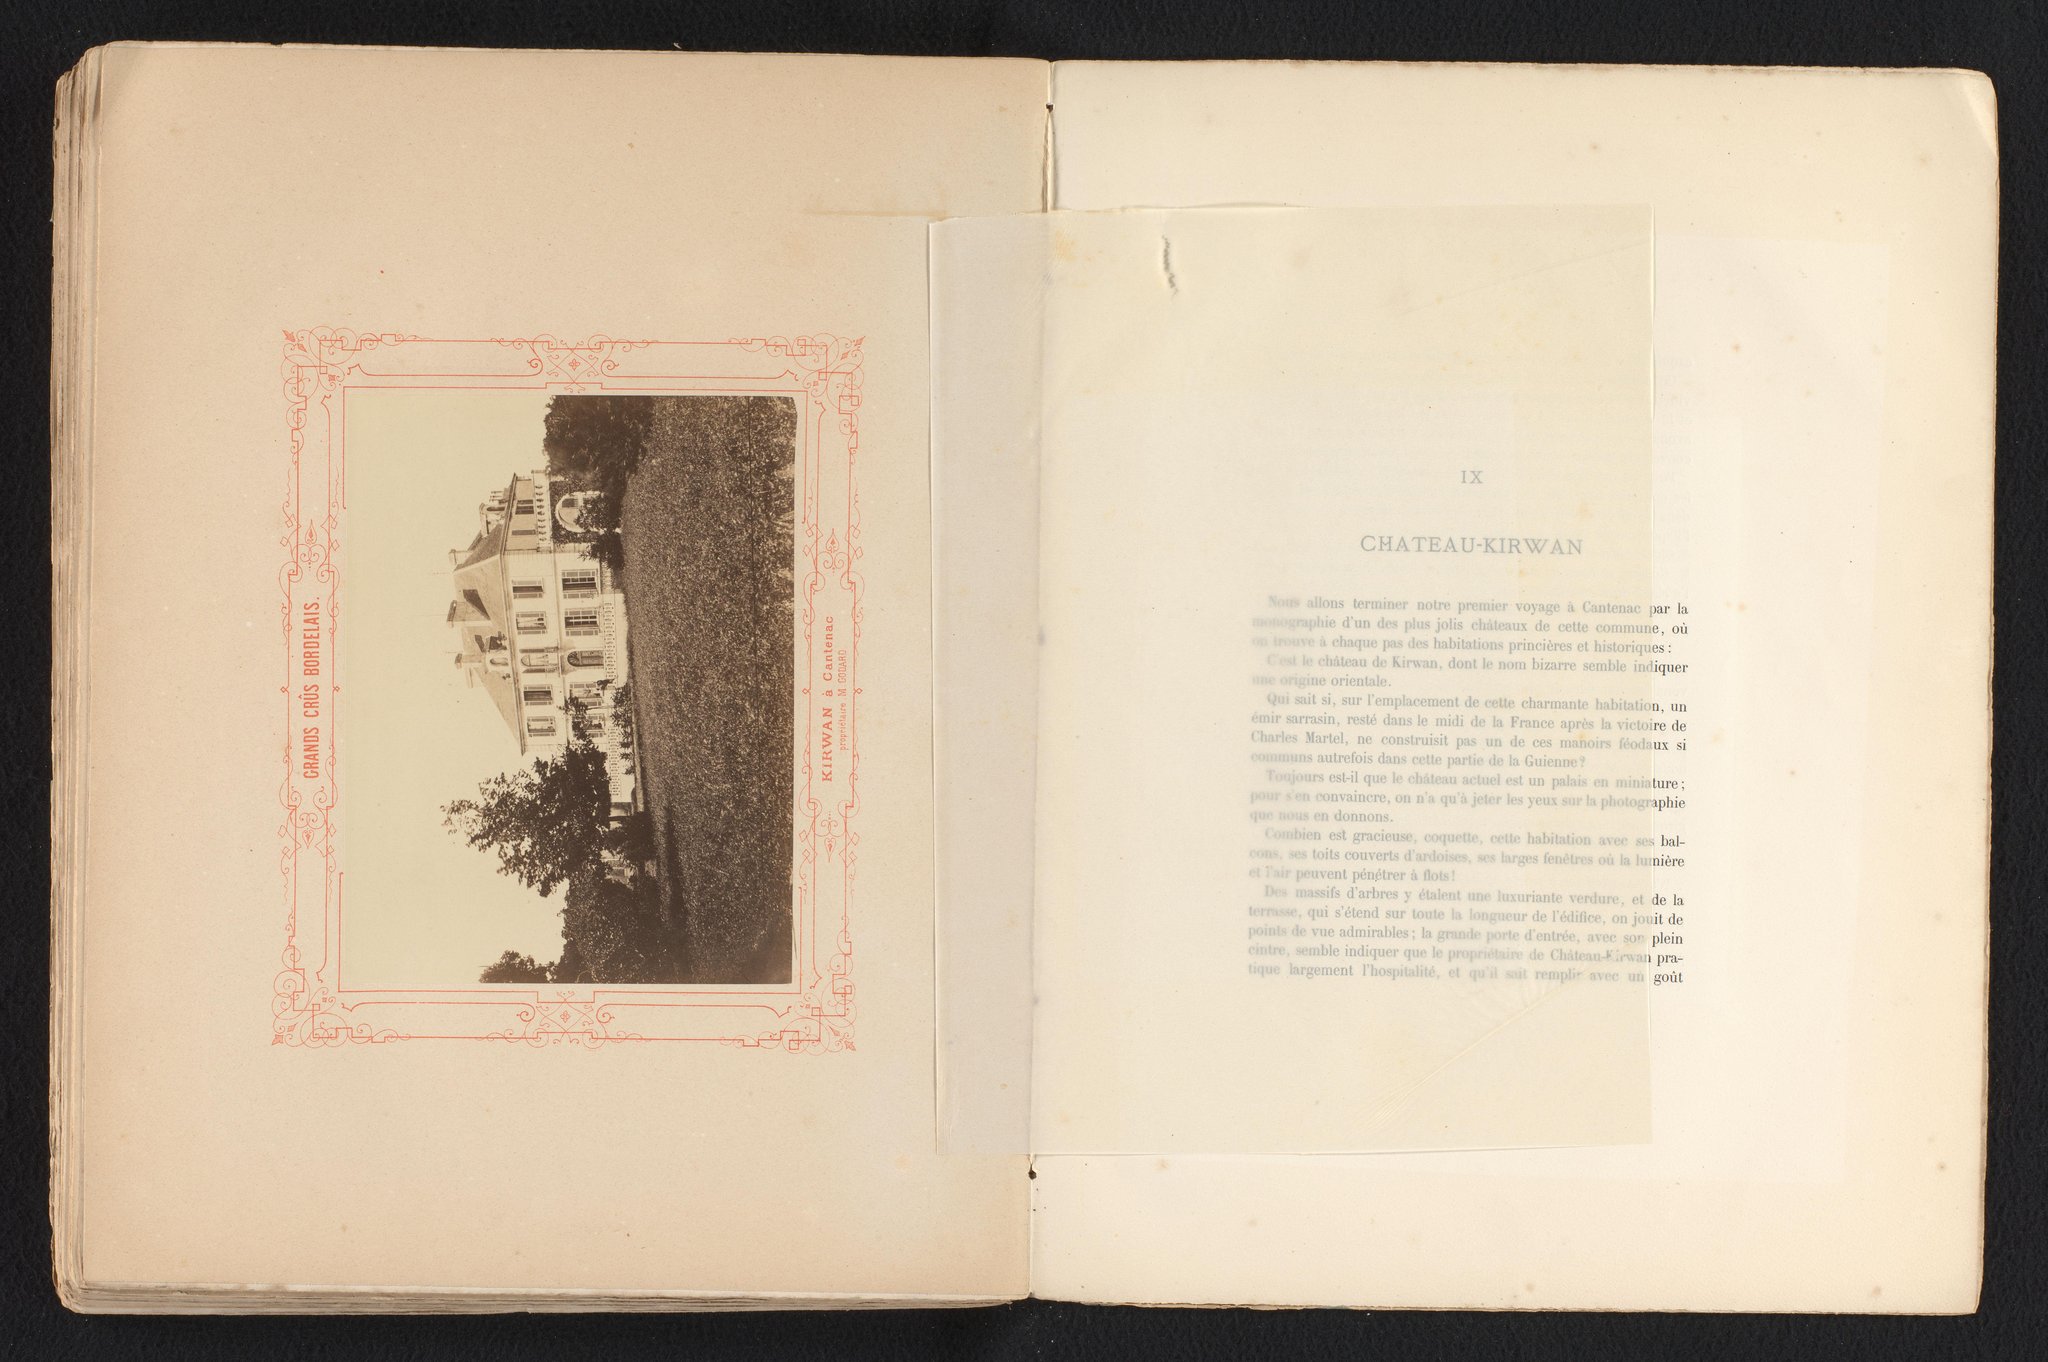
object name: photograph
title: Kirwan à Cantenac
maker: alfred danflou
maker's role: fotograaf, schrijver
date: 1862-1867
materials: paper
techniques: albumen print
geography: cantenac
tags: castle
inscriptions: inscription: ‘propriétaire: M. GODARD.’